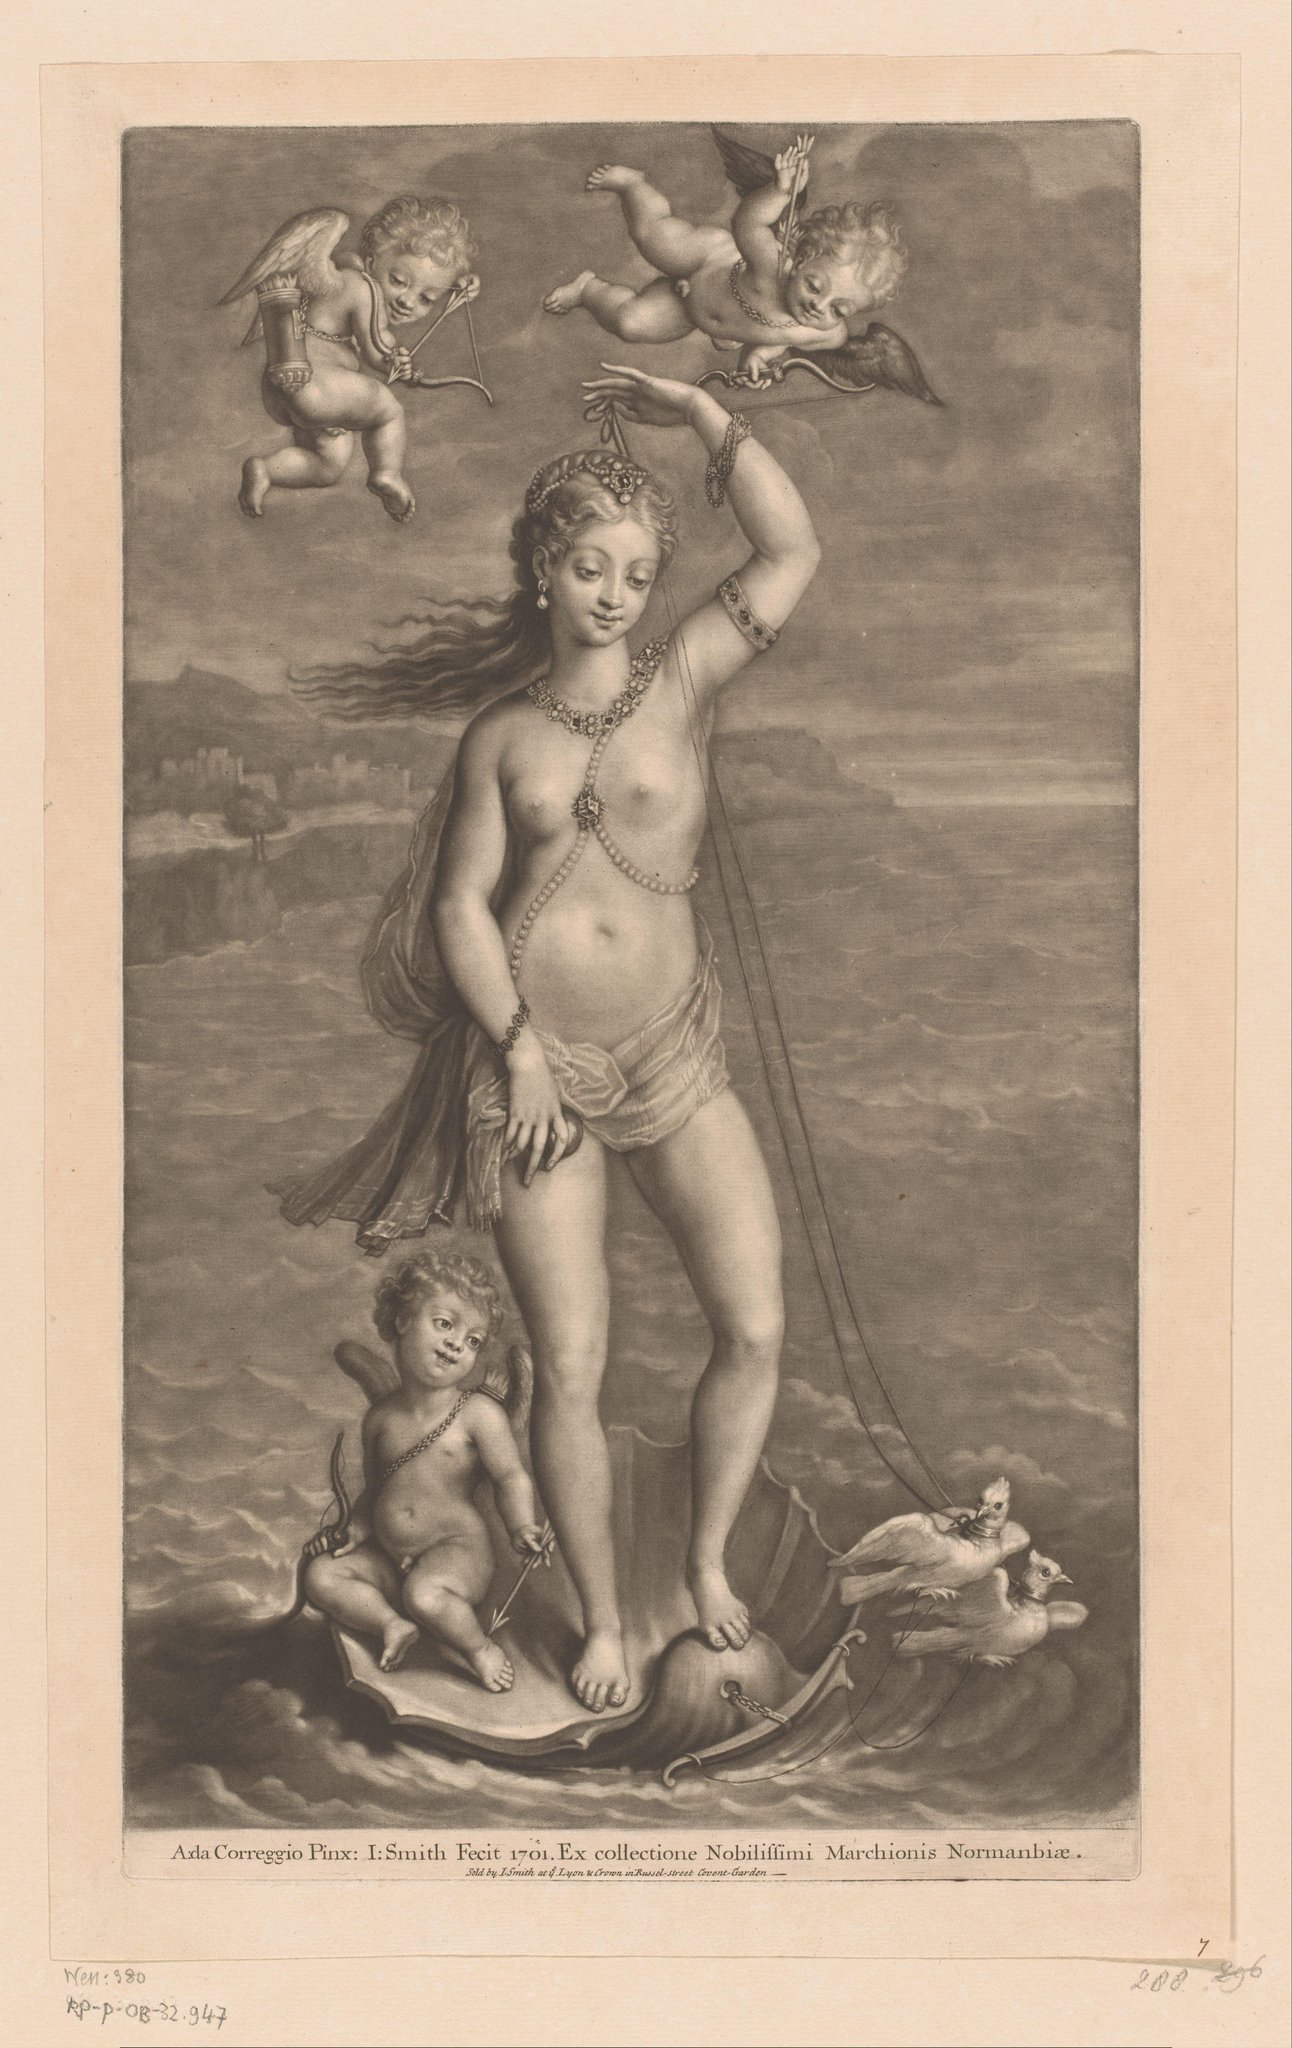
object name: print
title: Venus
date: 1701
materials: paper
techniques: mezzotint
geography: london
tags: venus, standing on a shell, sails with her veil over the water (alternatively she is riding on a dolphin): venus marina, cupids: 'amores', 'amoretti', 'putti'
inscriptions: collector's mark: Lugt 240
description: Tekst in het Latijn in de ondermarge. De schelp wordt getrokken door twee aangelijnde duiven.